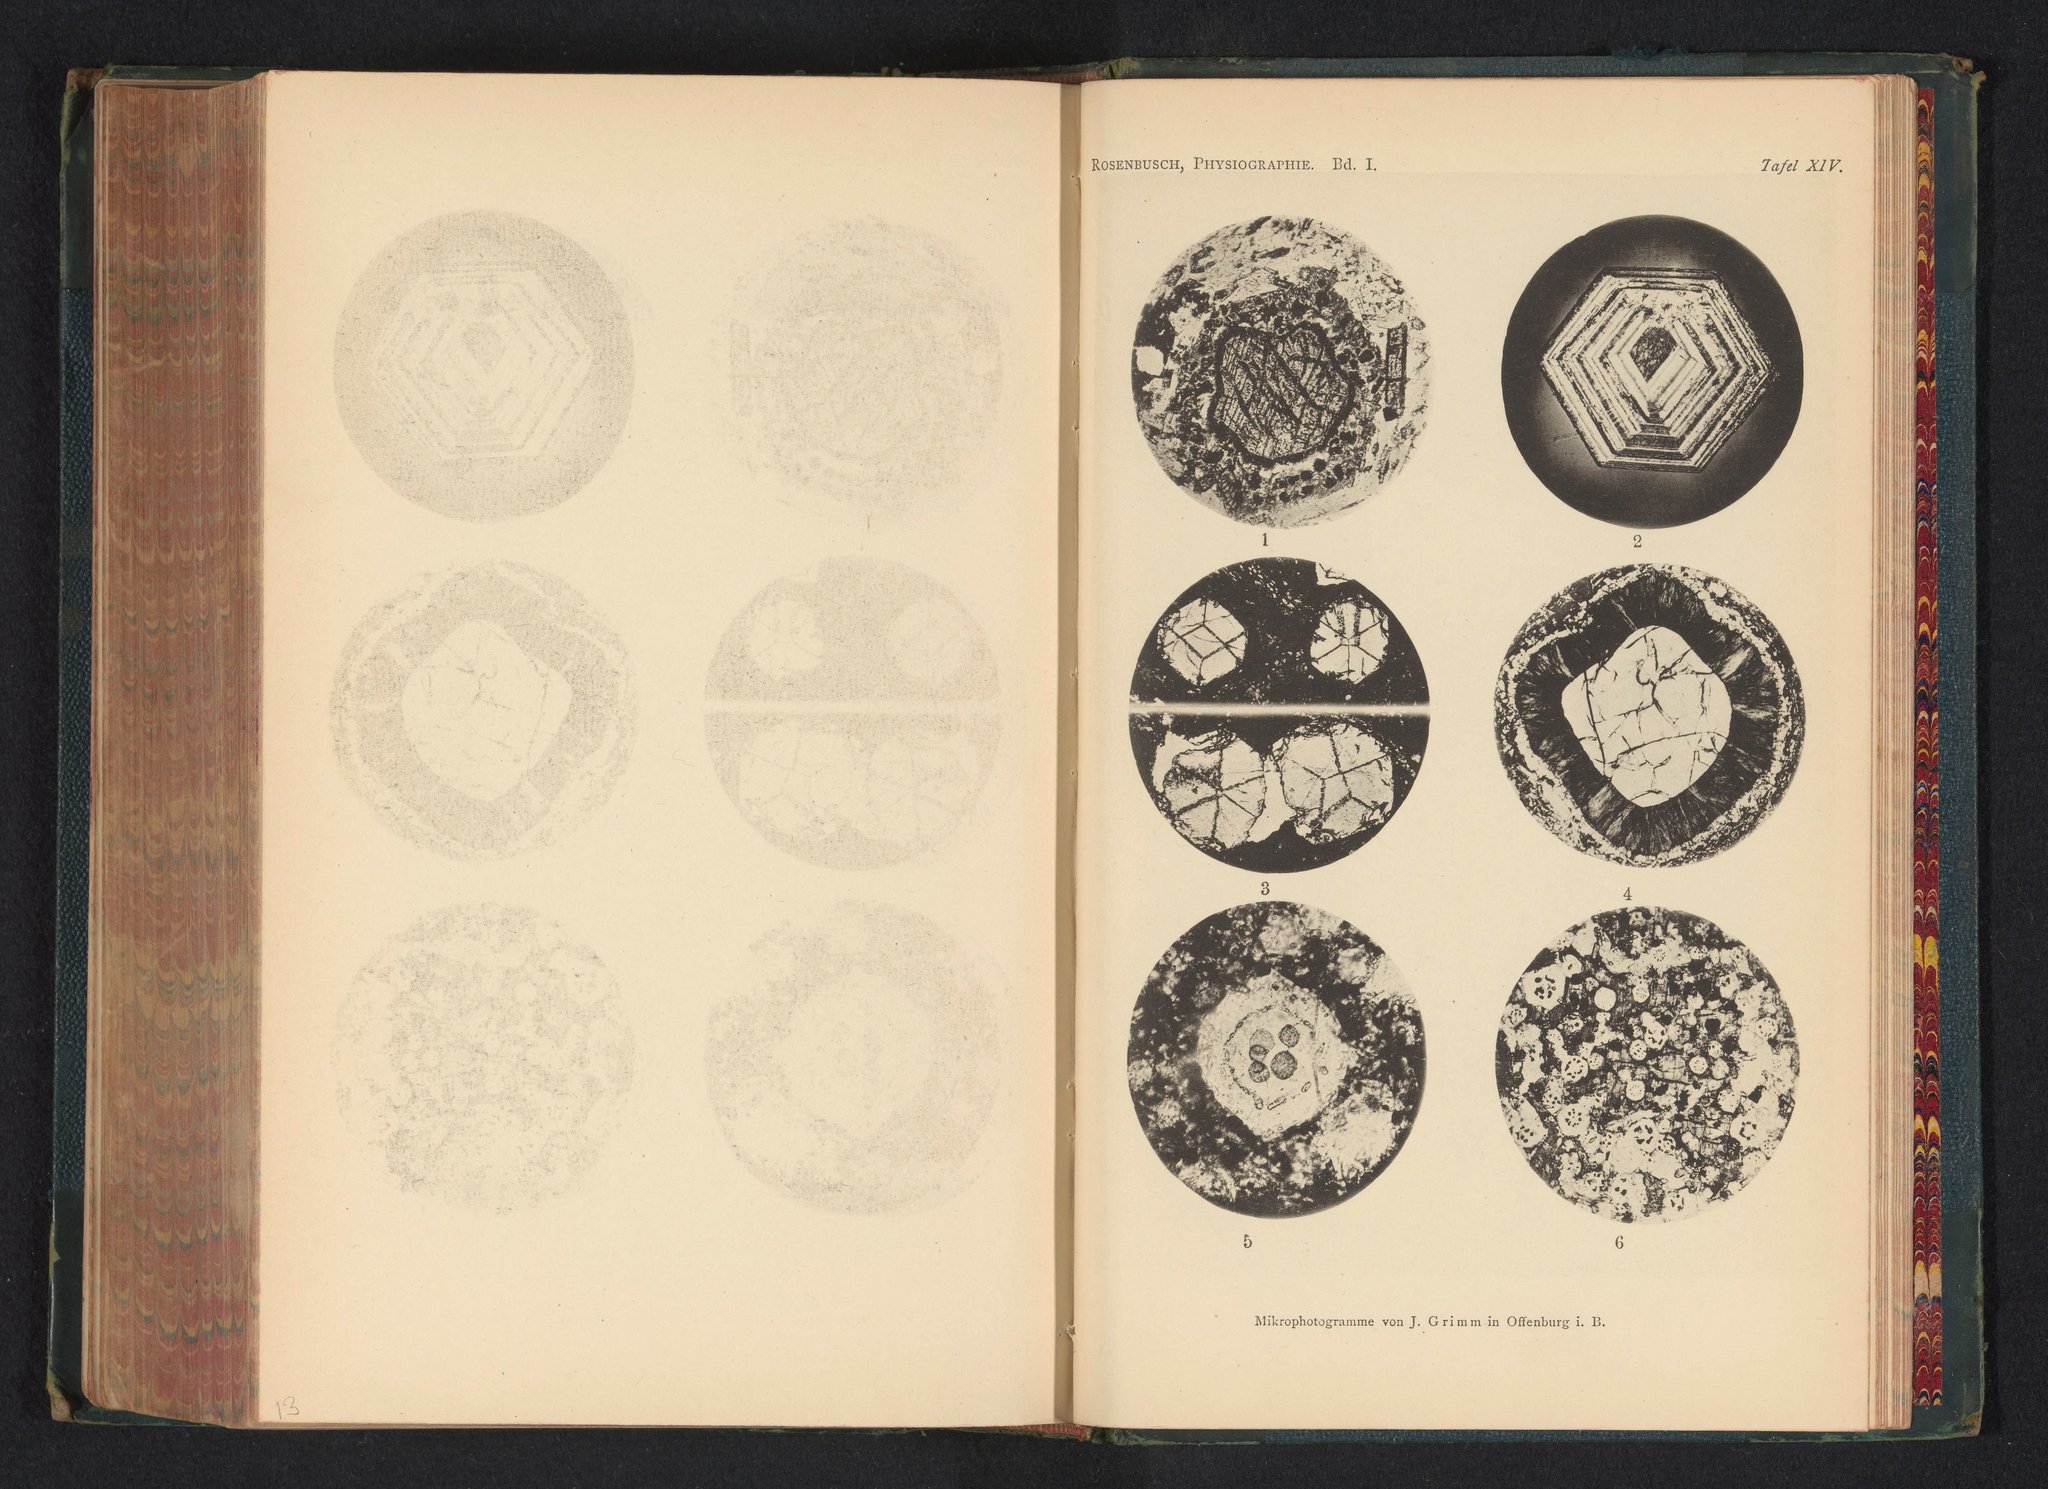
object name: page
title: Zes microscopische vergrotingen van mineralen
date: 1880-1885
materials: paper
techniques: photograph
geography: greifswald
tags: minerals and metals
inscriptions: number: ‘1 (...) 6’, number: ‘Tafel XIV’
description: Afbeelding 1 is augiet en magnetiet, 2, 3 en 4 is granaat, 5 is leuciet en 6 is leuciet.